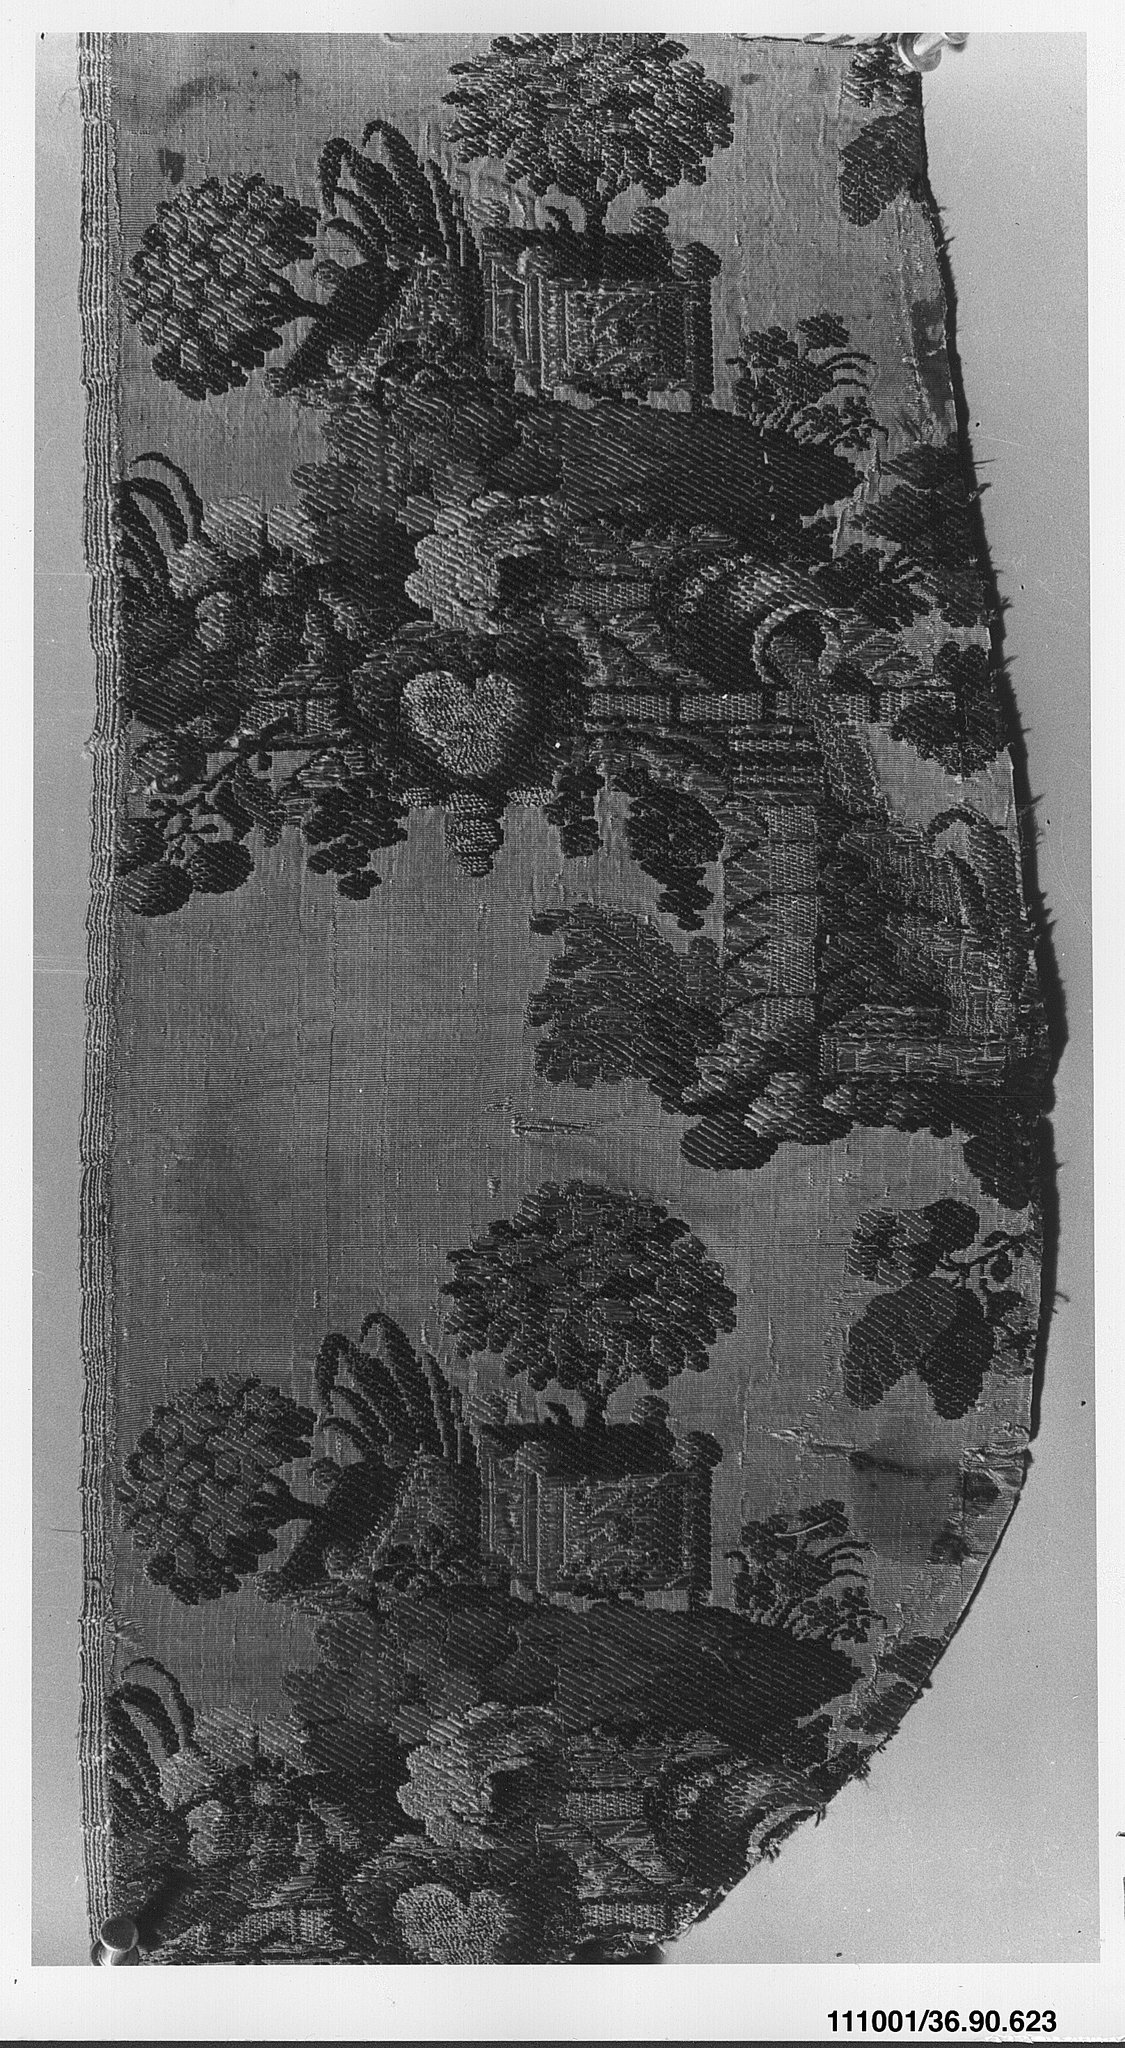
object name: piece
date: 1735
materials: metal thread, silk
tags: flowers,leaves